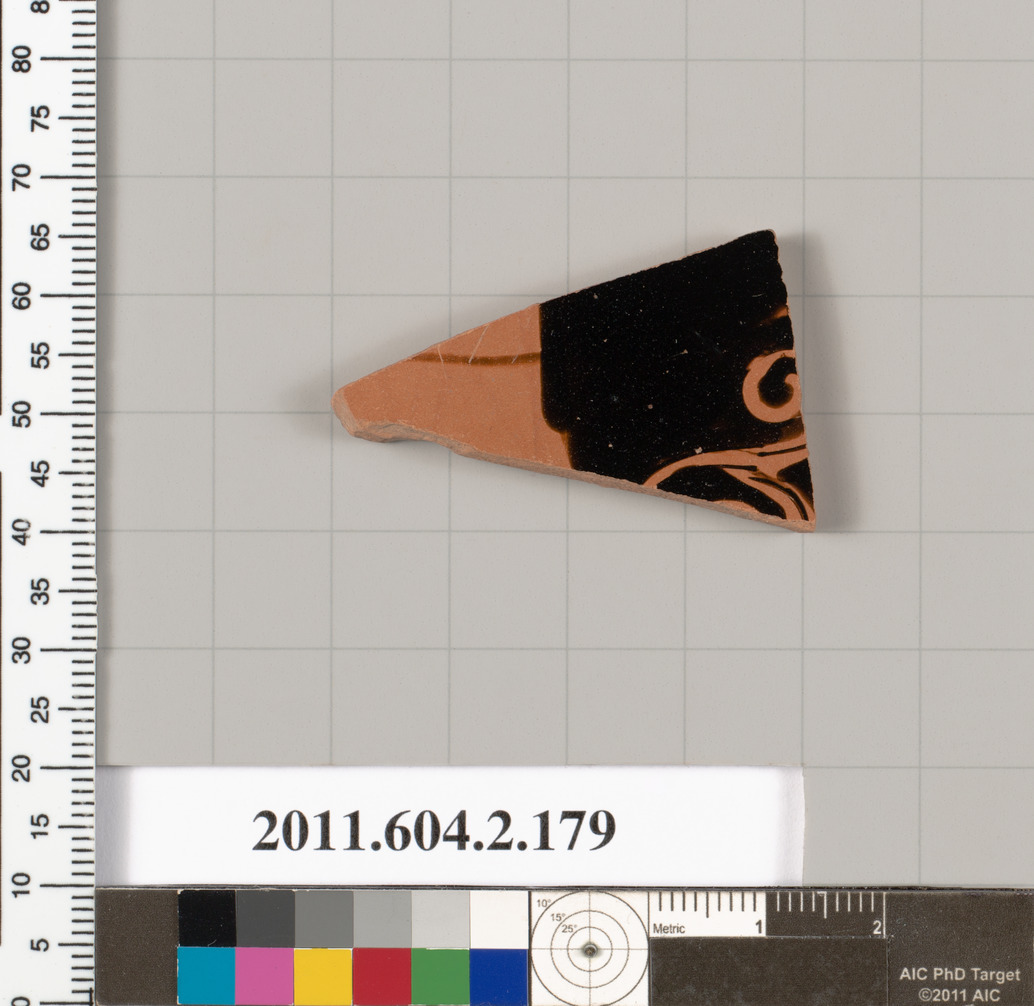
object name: stamnos fragment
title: Terracotta fragment of a stamnos (jar)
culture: greek, attic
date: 450-426 BCE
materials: terracotta